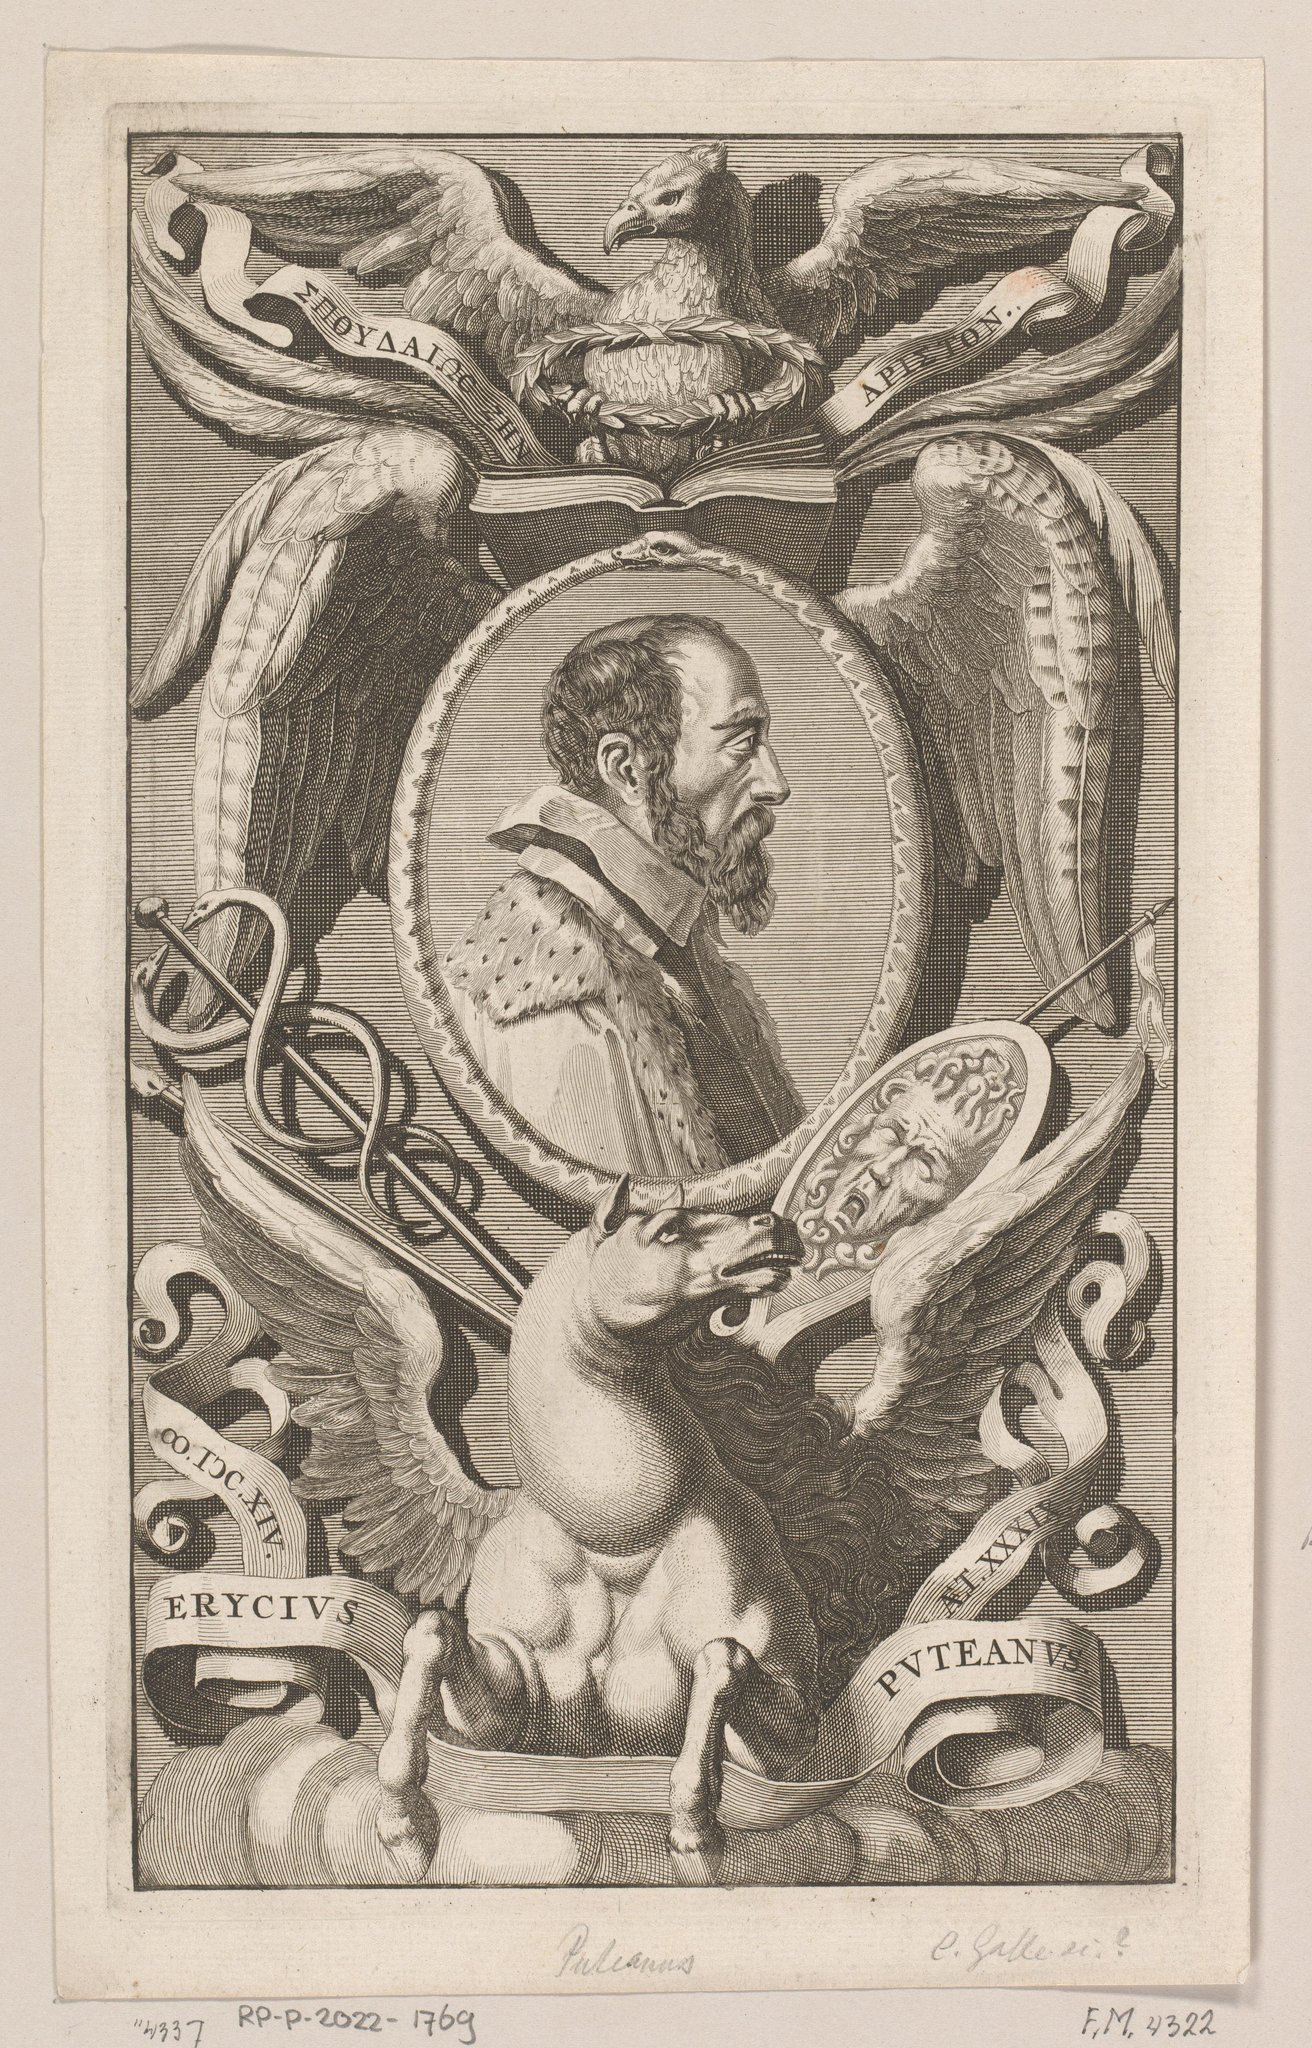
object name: print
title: Portret van Erycius Puteanus op 39-jarige leeftijd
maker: Anonymous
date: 1614-1650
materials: paper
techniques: engraving, etching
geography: antwerp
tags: erycius puteanus, pegasus, the winged horse, predatory birds: eagle, historical persons, portrait of a writer, caduceus (staff with two snakes, attribute of mercury), attributes of medusa